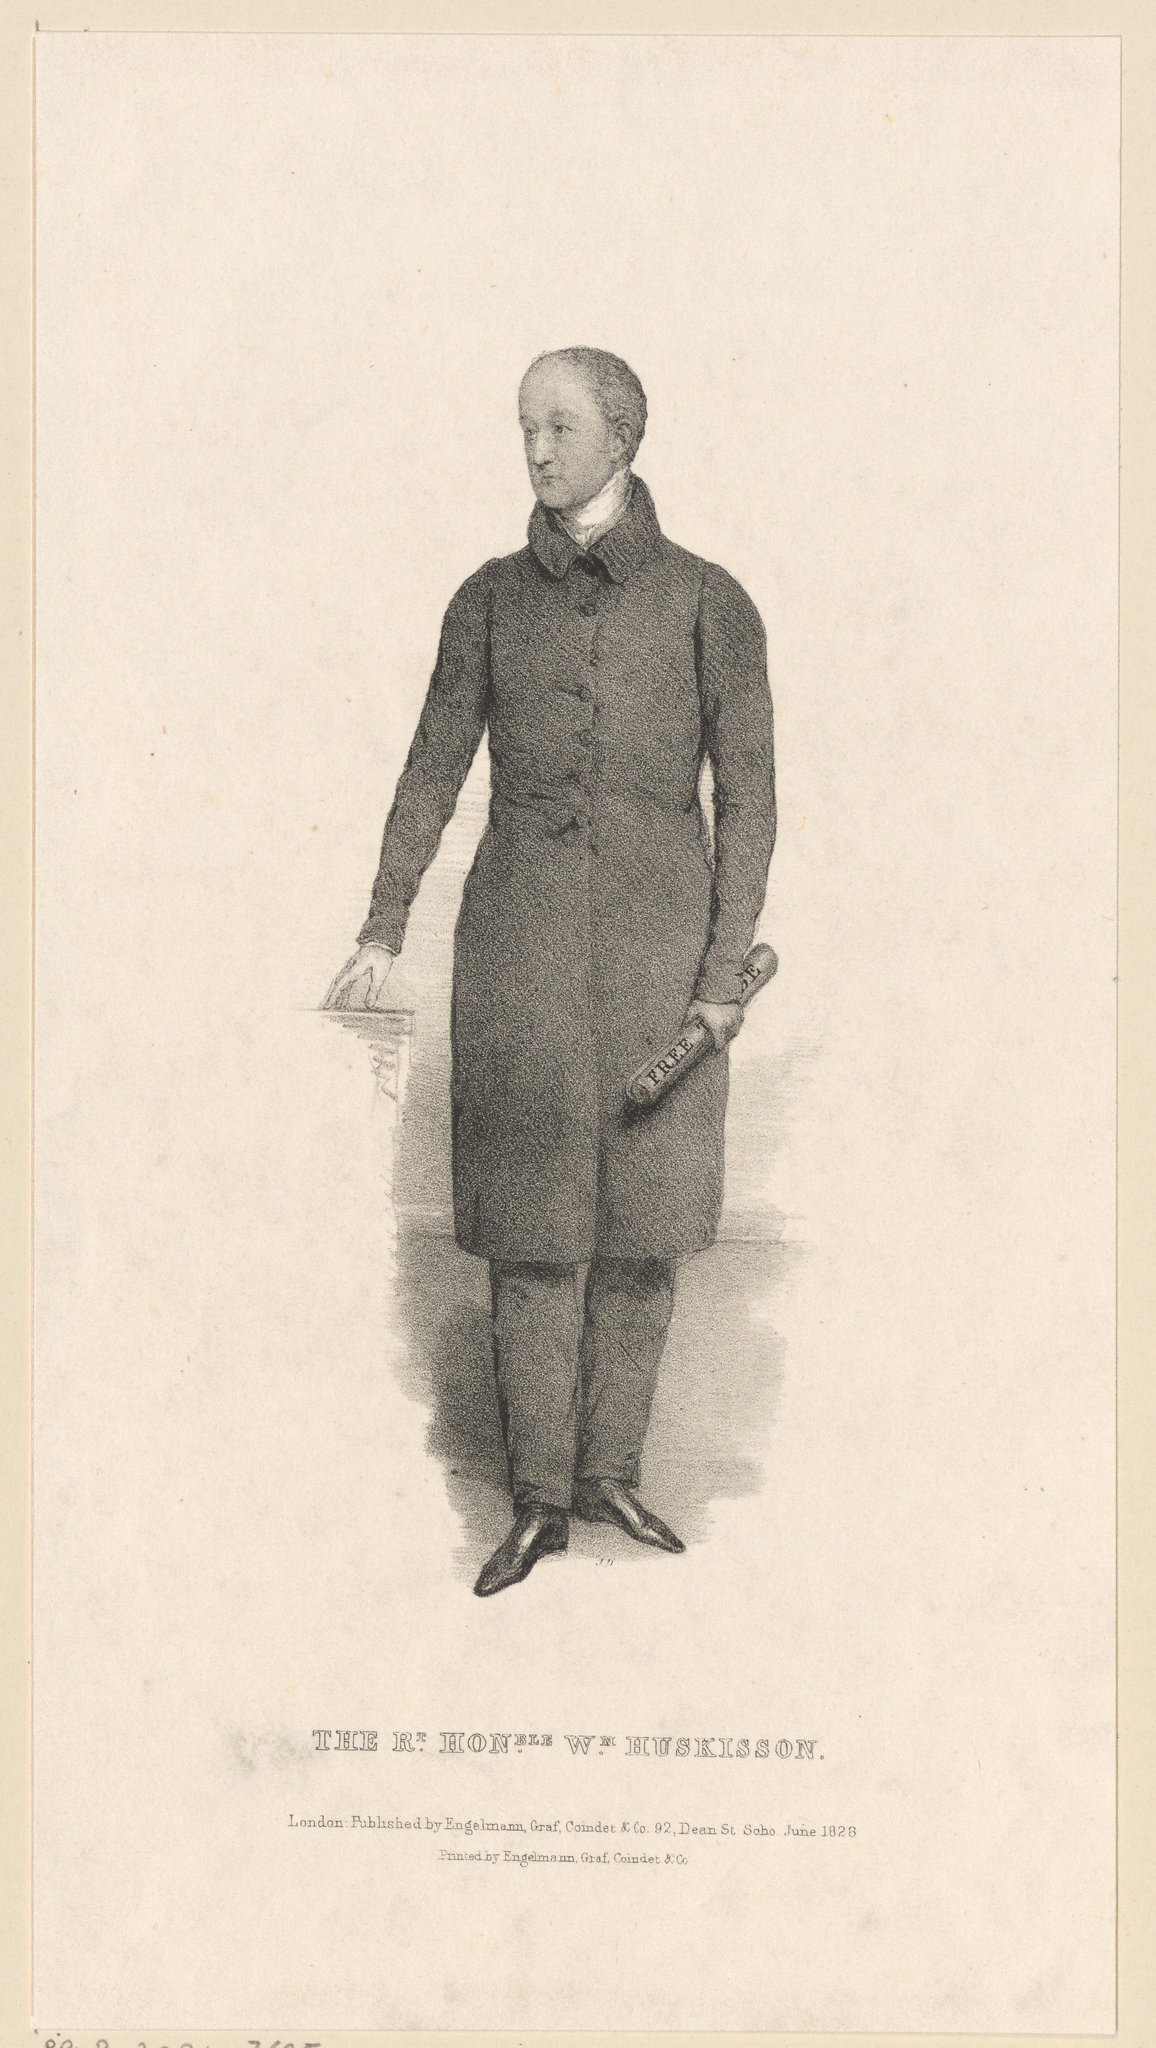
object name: print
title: Portret van William Huskisson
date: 1806-1828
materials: paper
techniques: lithograph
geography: london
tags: historical persons, politician, e.g. party leader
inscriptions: date